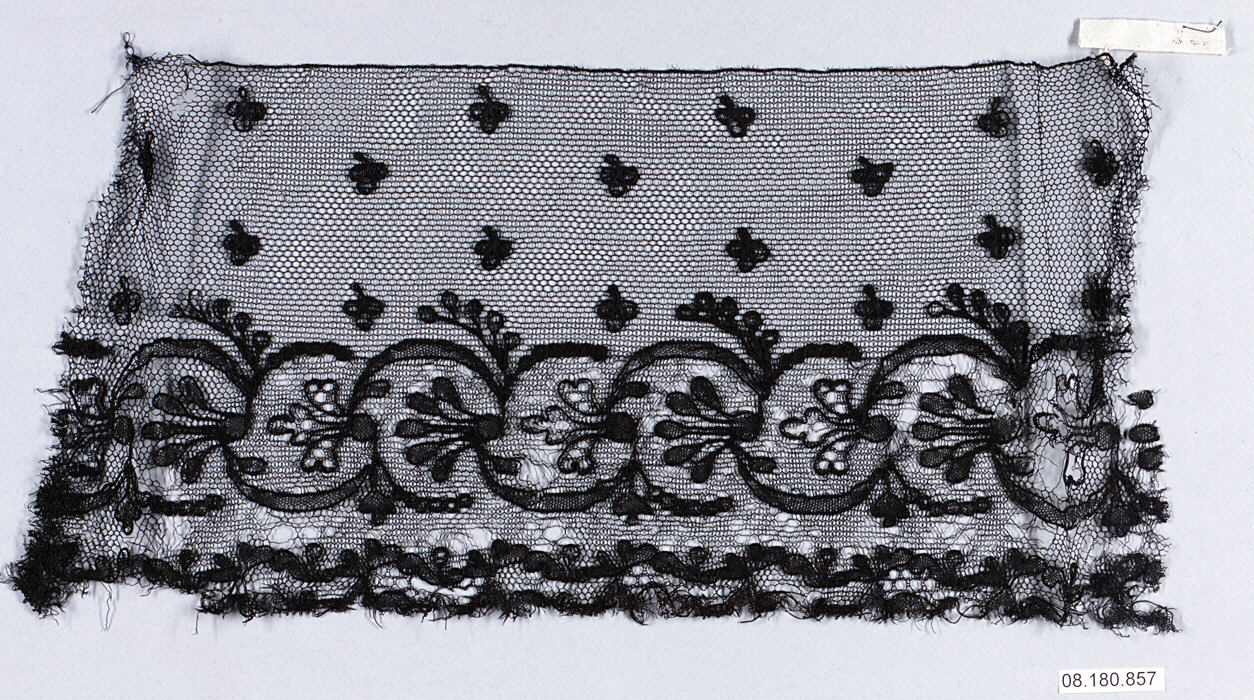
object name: piece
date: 1801-1900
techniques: lace